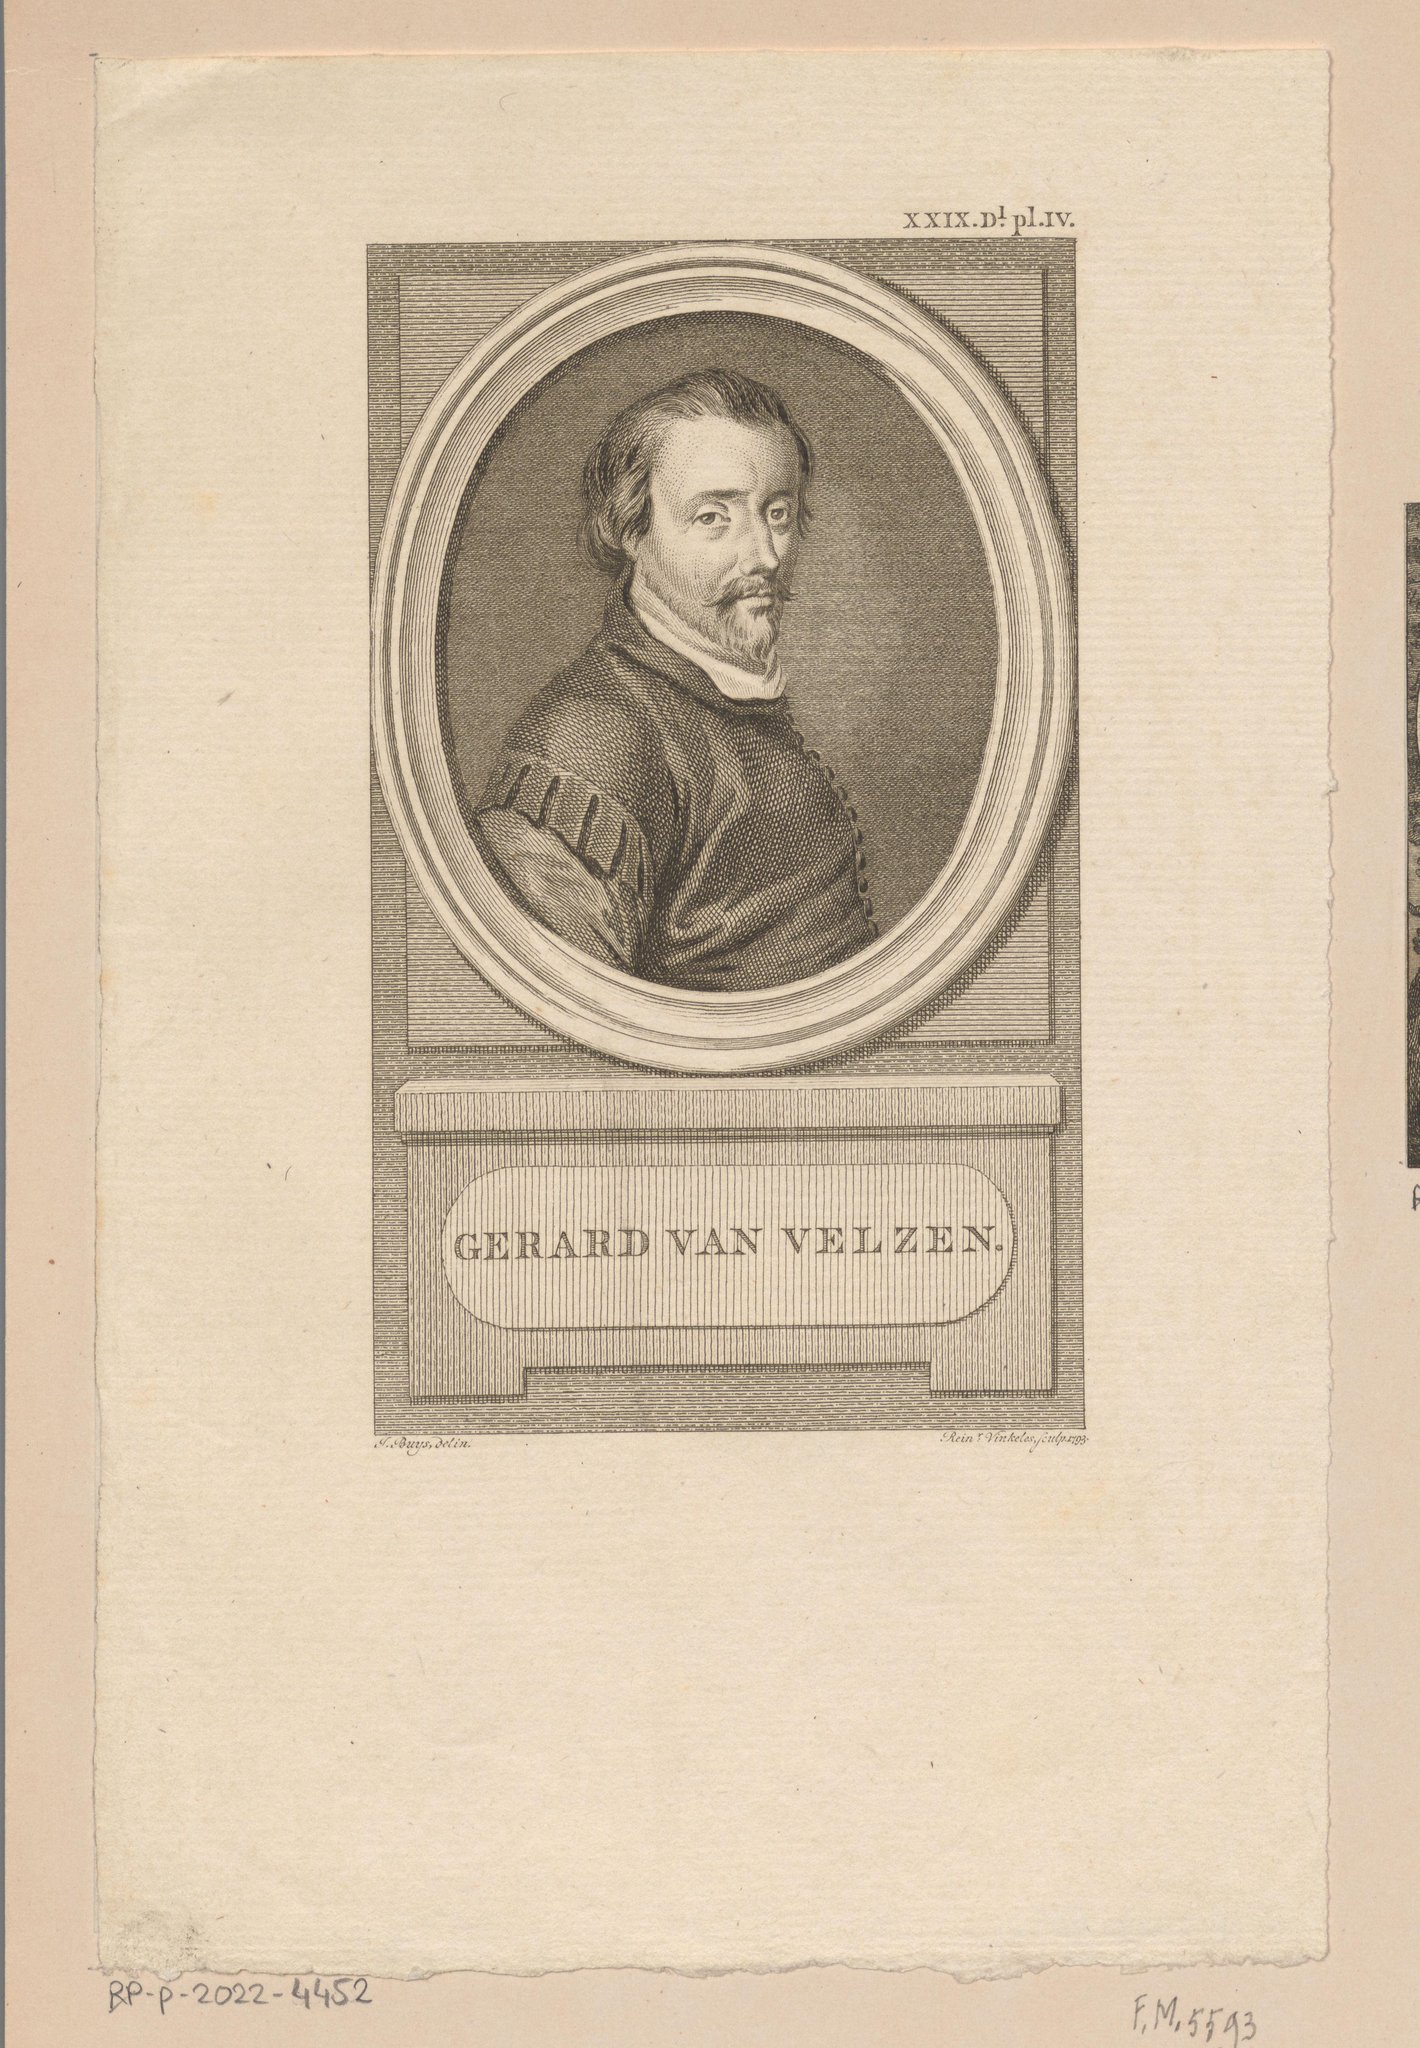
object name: book illustration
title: Portret van Gerard van Velzen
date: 1793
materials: paper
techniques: etching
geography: amsterdam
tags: historical persons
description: Prent uit: Kok, Jacobus. Vaderlandsch woordenboek: met kaarten, plaaten en pourtraitten. Amsterdam: Johannes Allart, 1793, dl. 29.